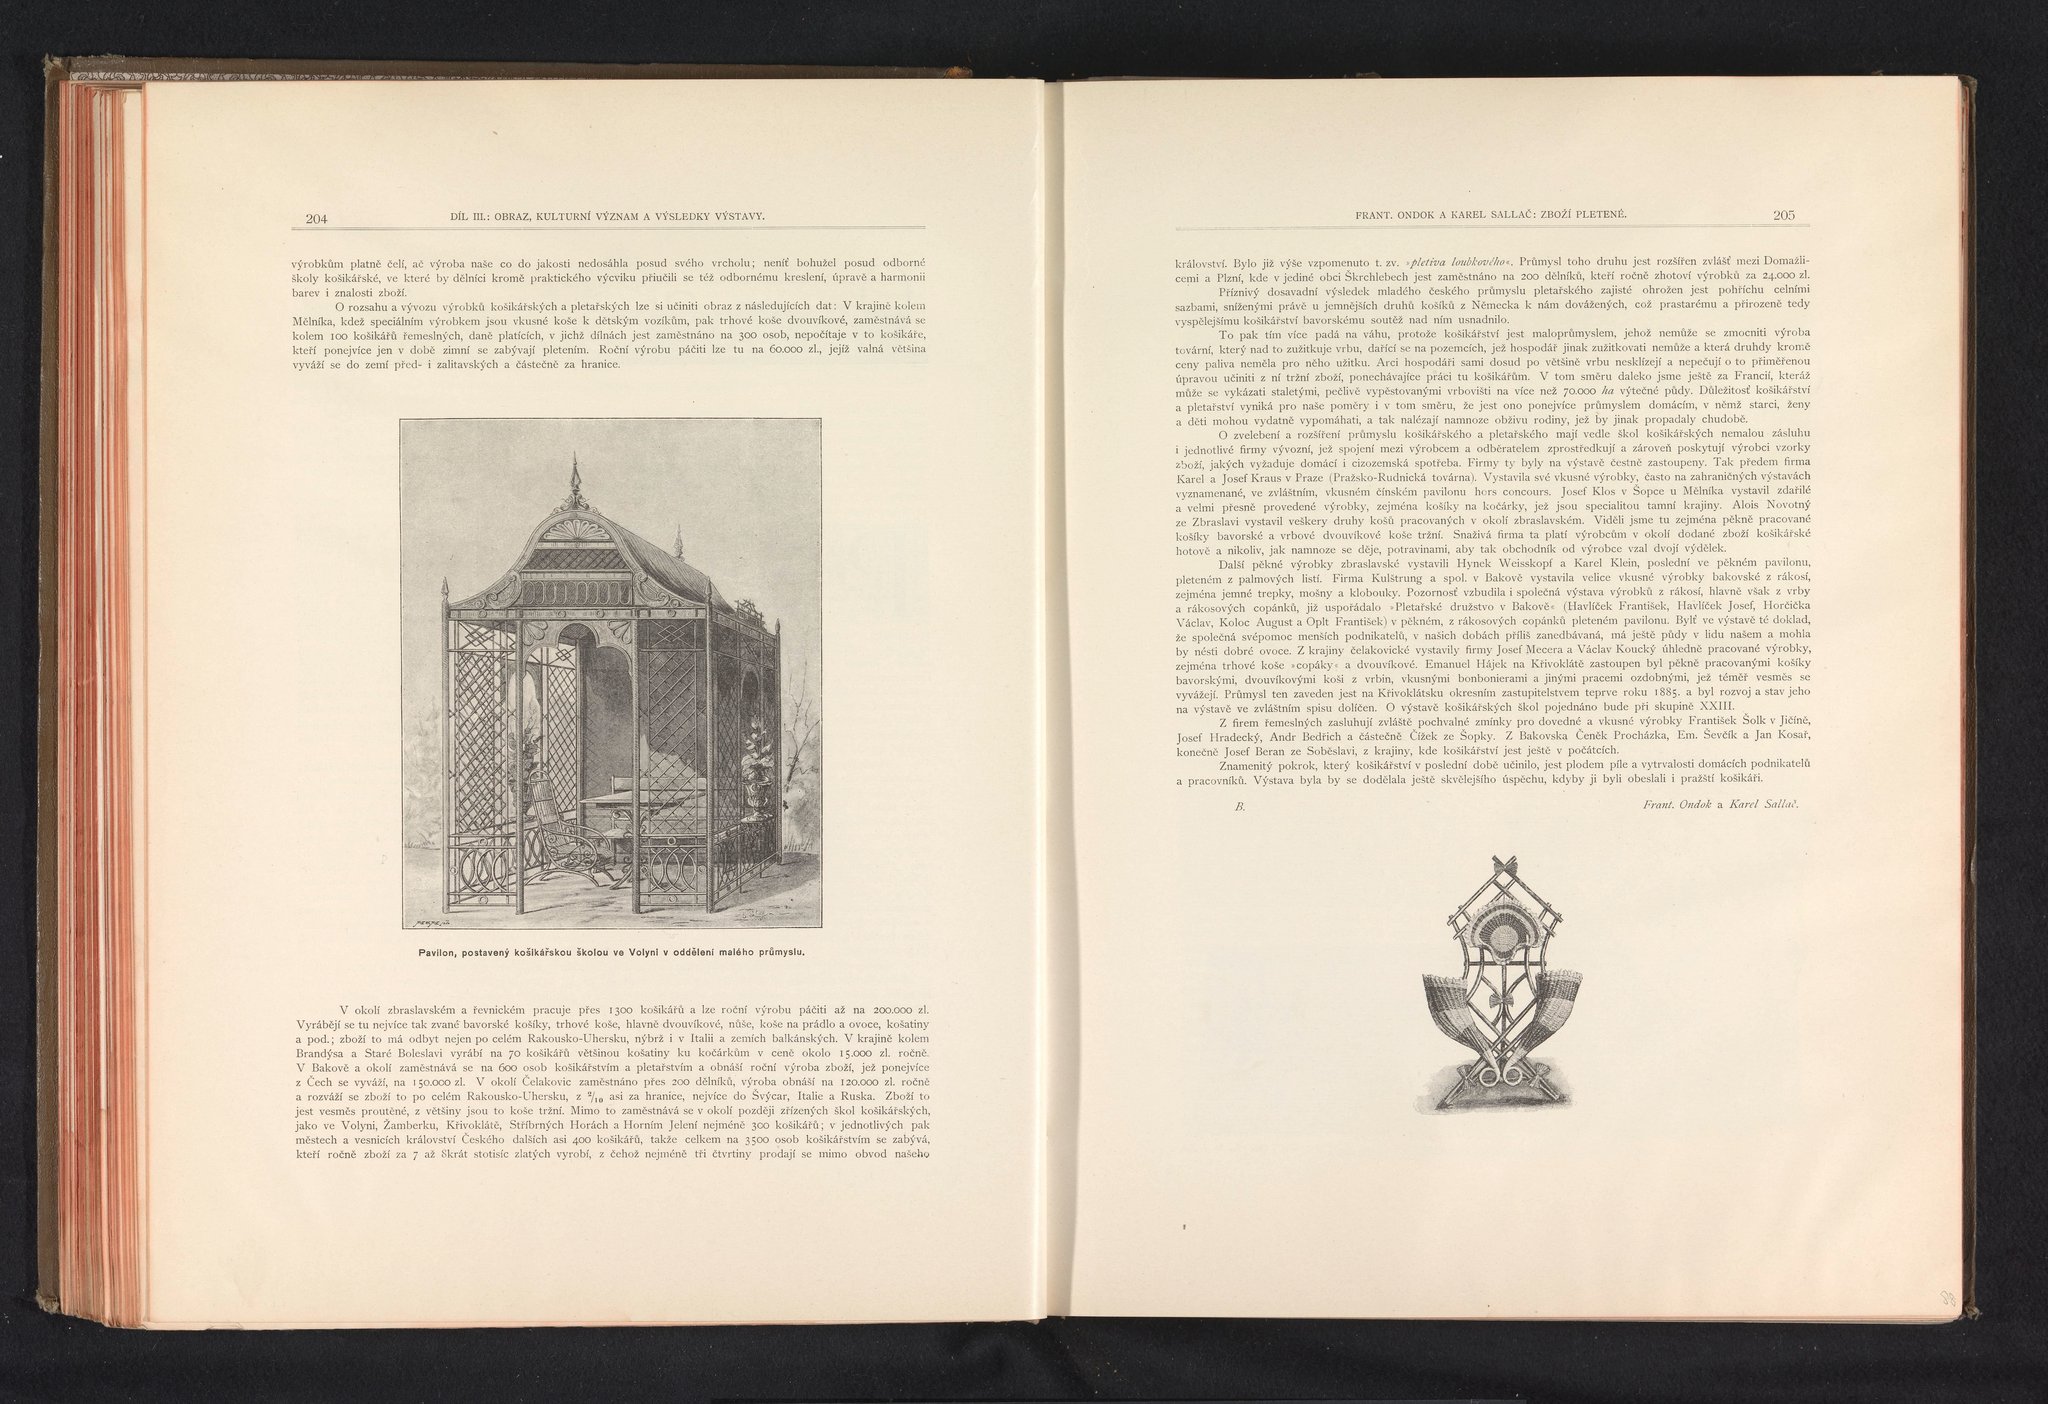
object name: photomechanical print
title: Fotoreproductie van een tekening, voorstellende een paviljoen te Praag, gebouwd door een mandenmakerijschool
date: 1890-1895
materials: paper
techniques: autotype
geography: prague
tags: façade (of house or building)